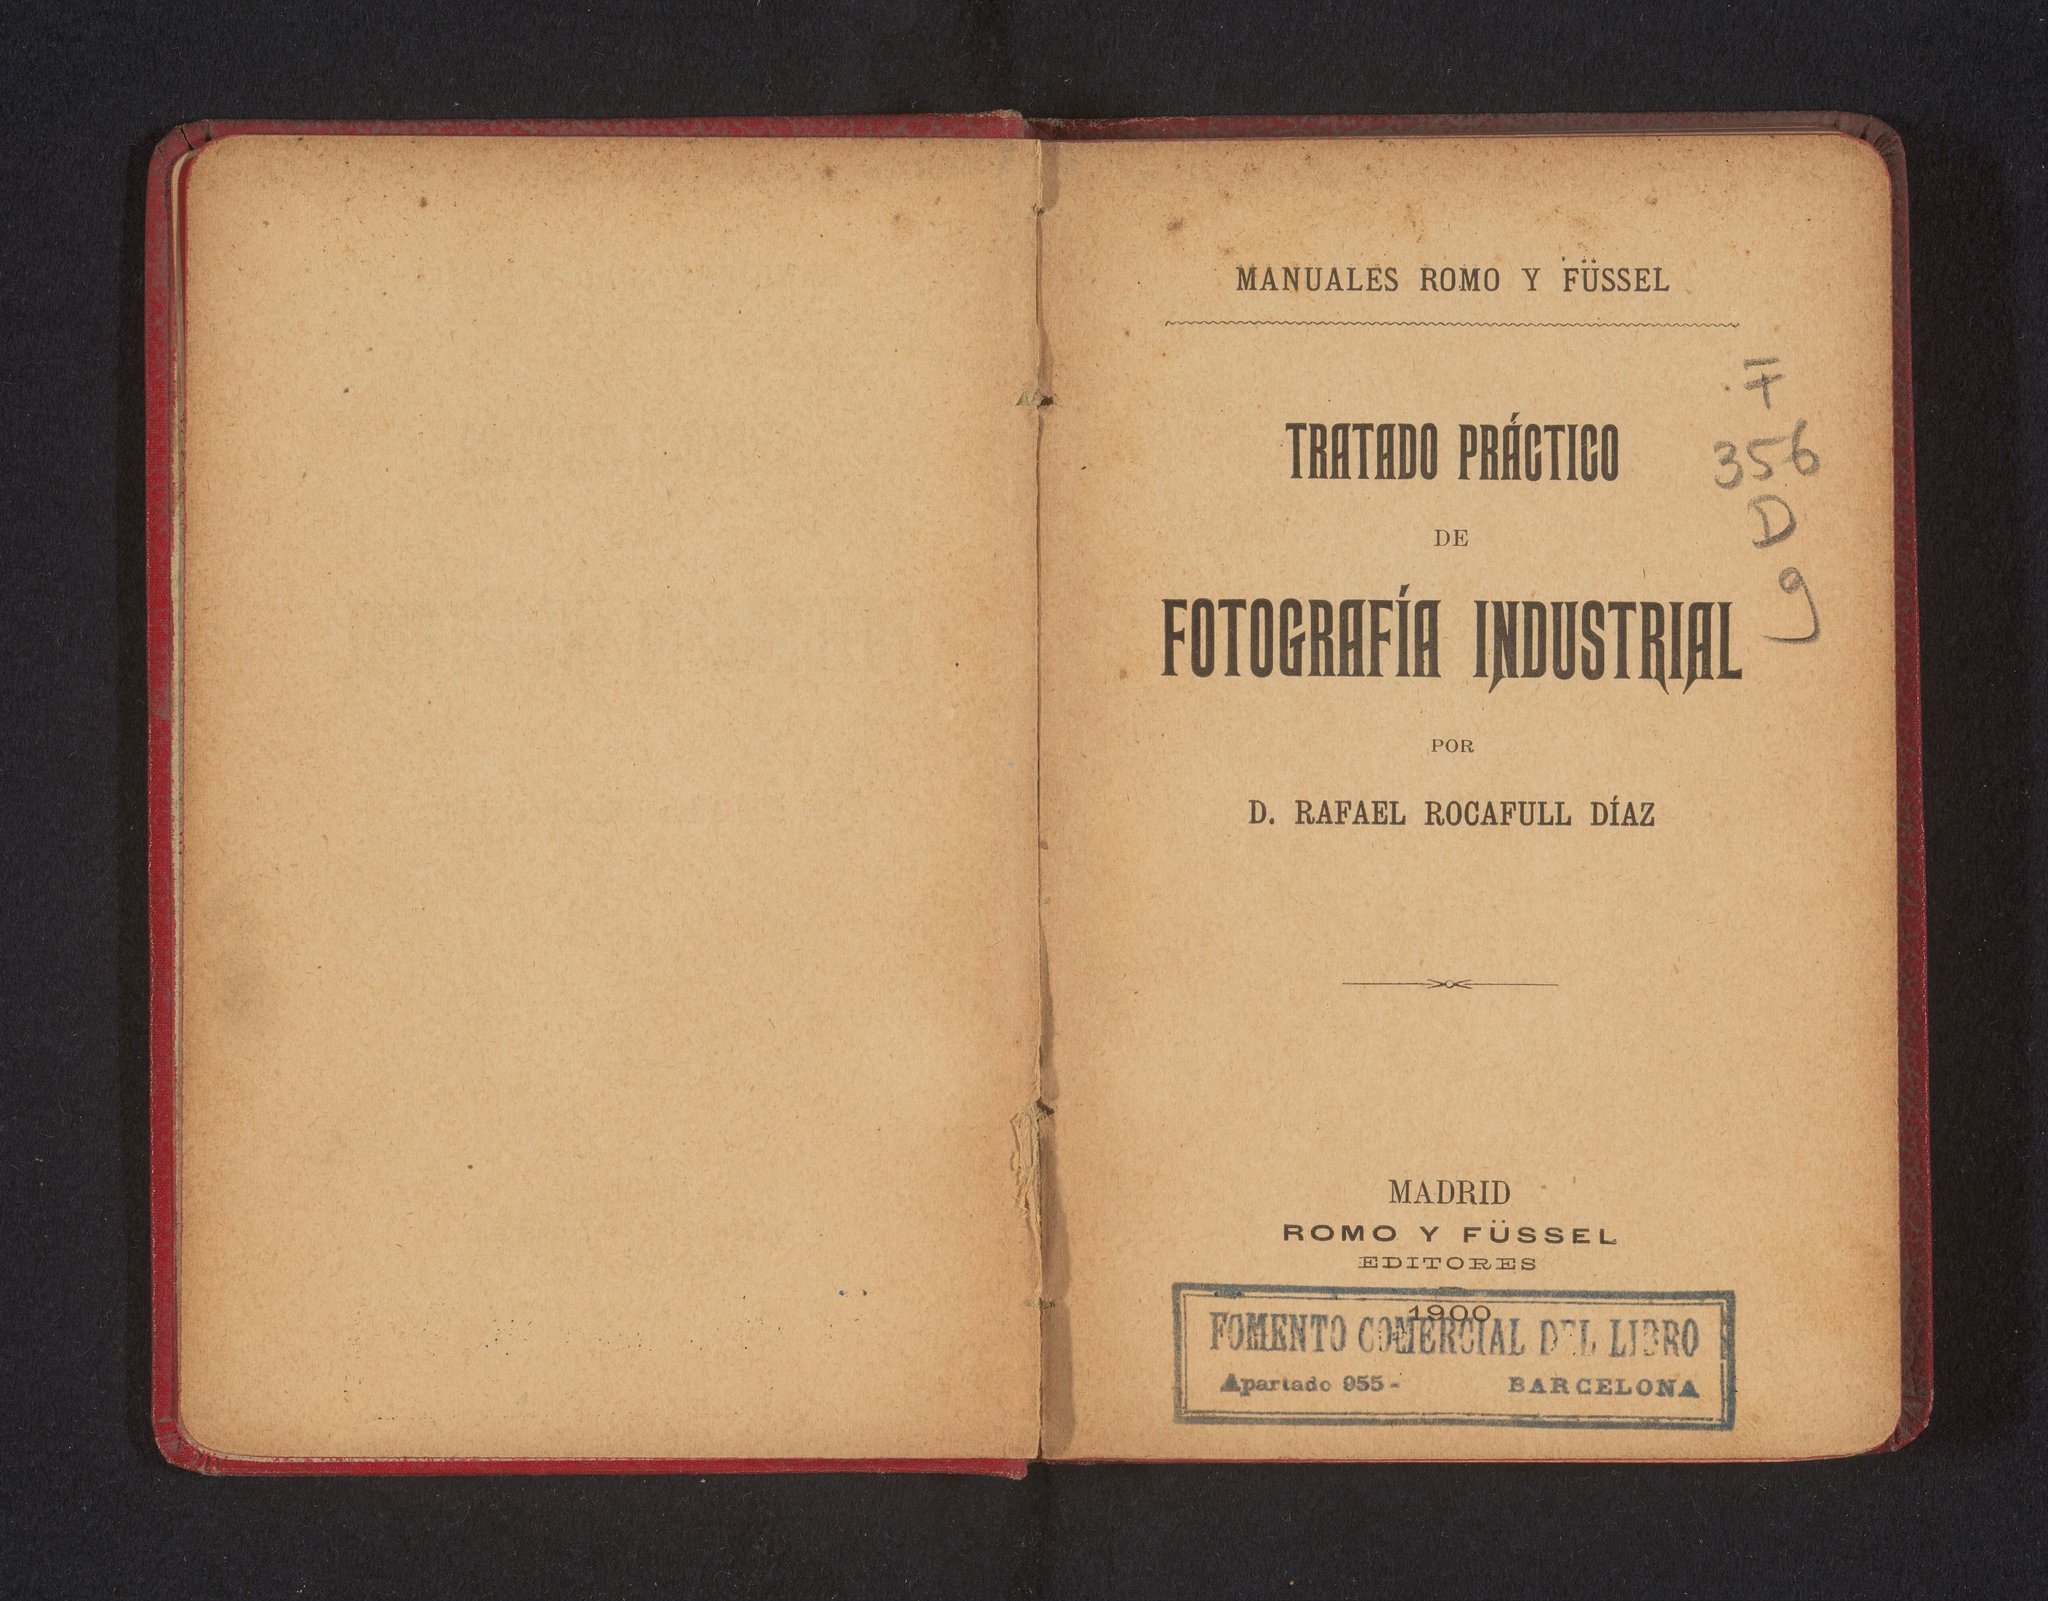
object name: book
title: Tratado práctico de fotografía industrial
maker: rafael rocafull díaz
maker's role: auteur, fotograaf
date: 1900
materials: cardboard, linen, paper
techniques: printing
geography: madrid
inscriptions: inscription: ‘Athenea Libraria, imprenta papeleria objetos de escritorio Pelayo 34 Barcelona’